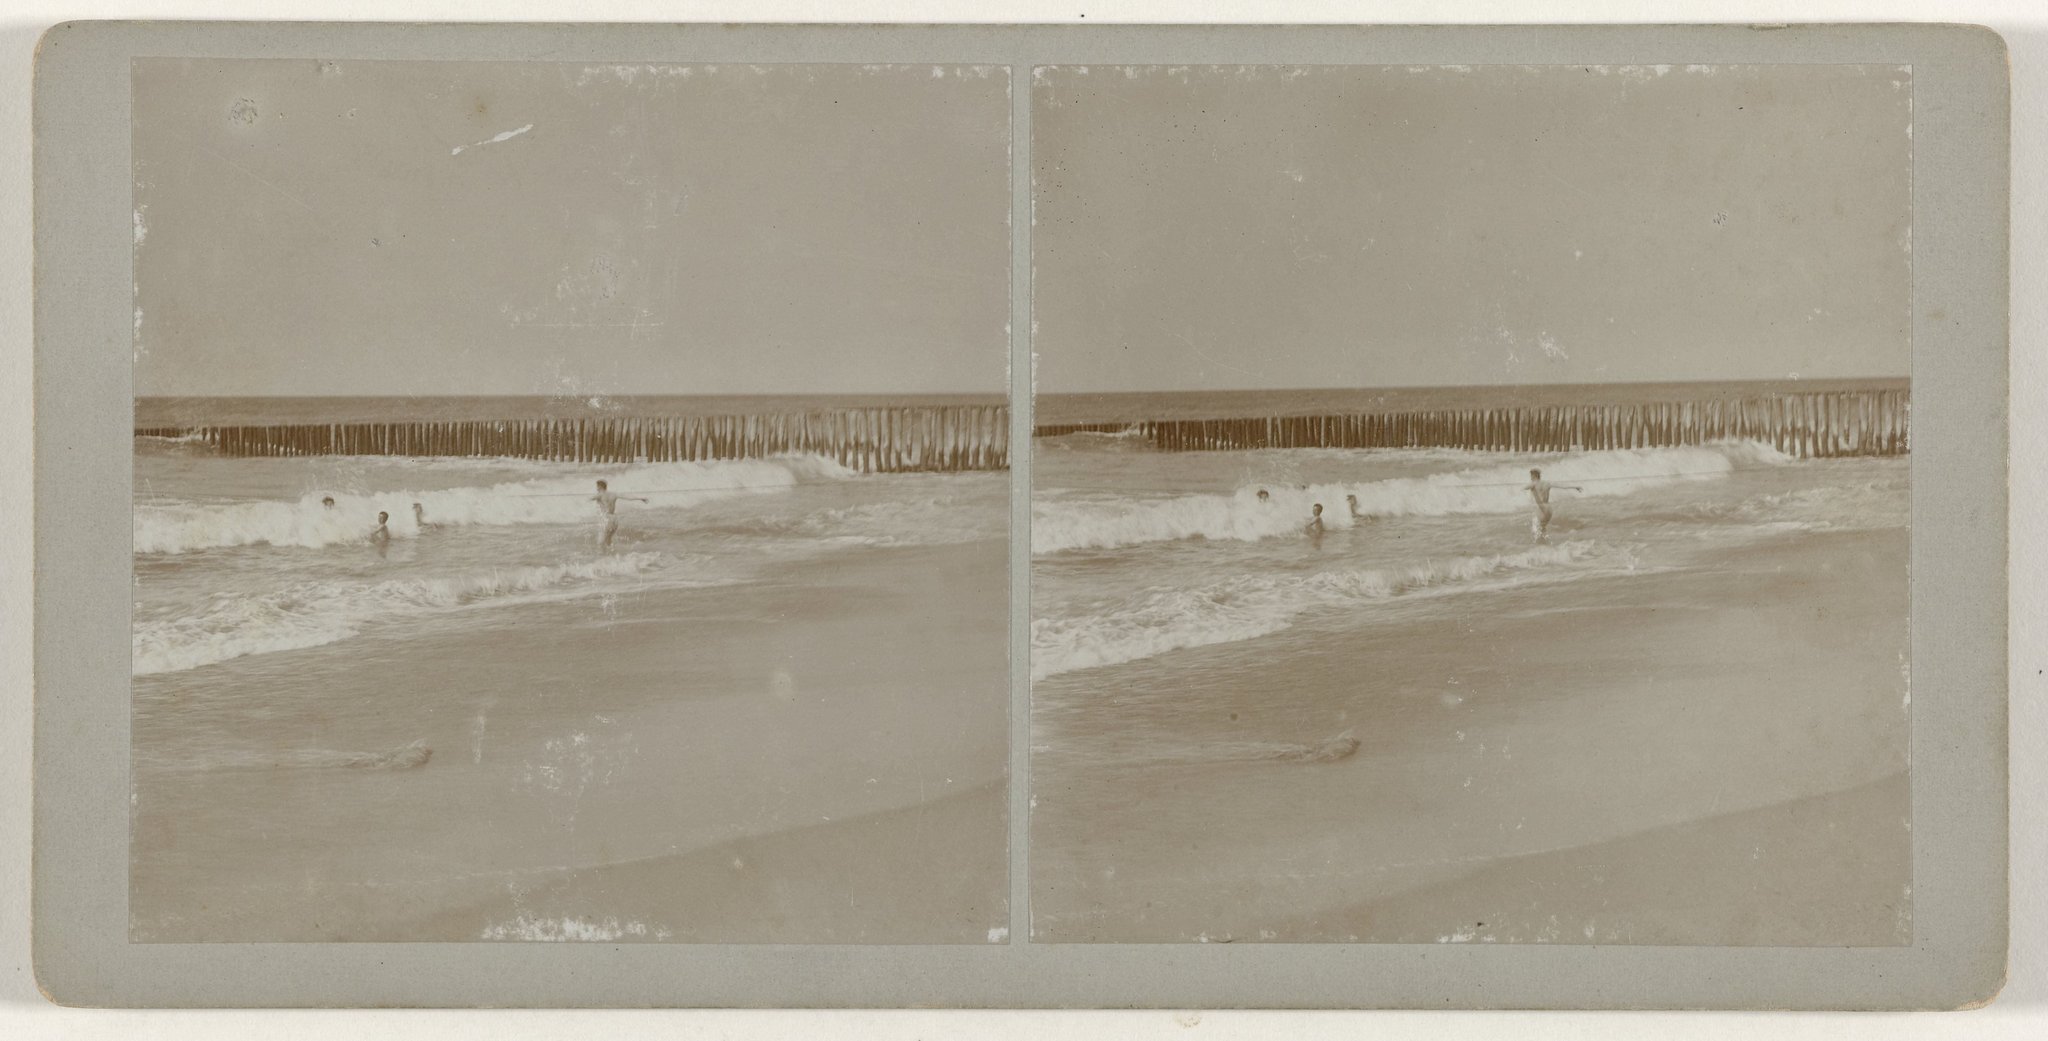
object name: stereograph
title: Familie Kessler zwemmend in zee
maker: geldolph adriaan kessler (dolph)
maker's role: fotograaf, industrieel, voetballer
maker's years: 1884-1945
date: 1899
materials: paper, photographic support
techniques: collodion silver print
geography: netherlands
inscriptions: caption: ‘aug. 1899 Domburg’